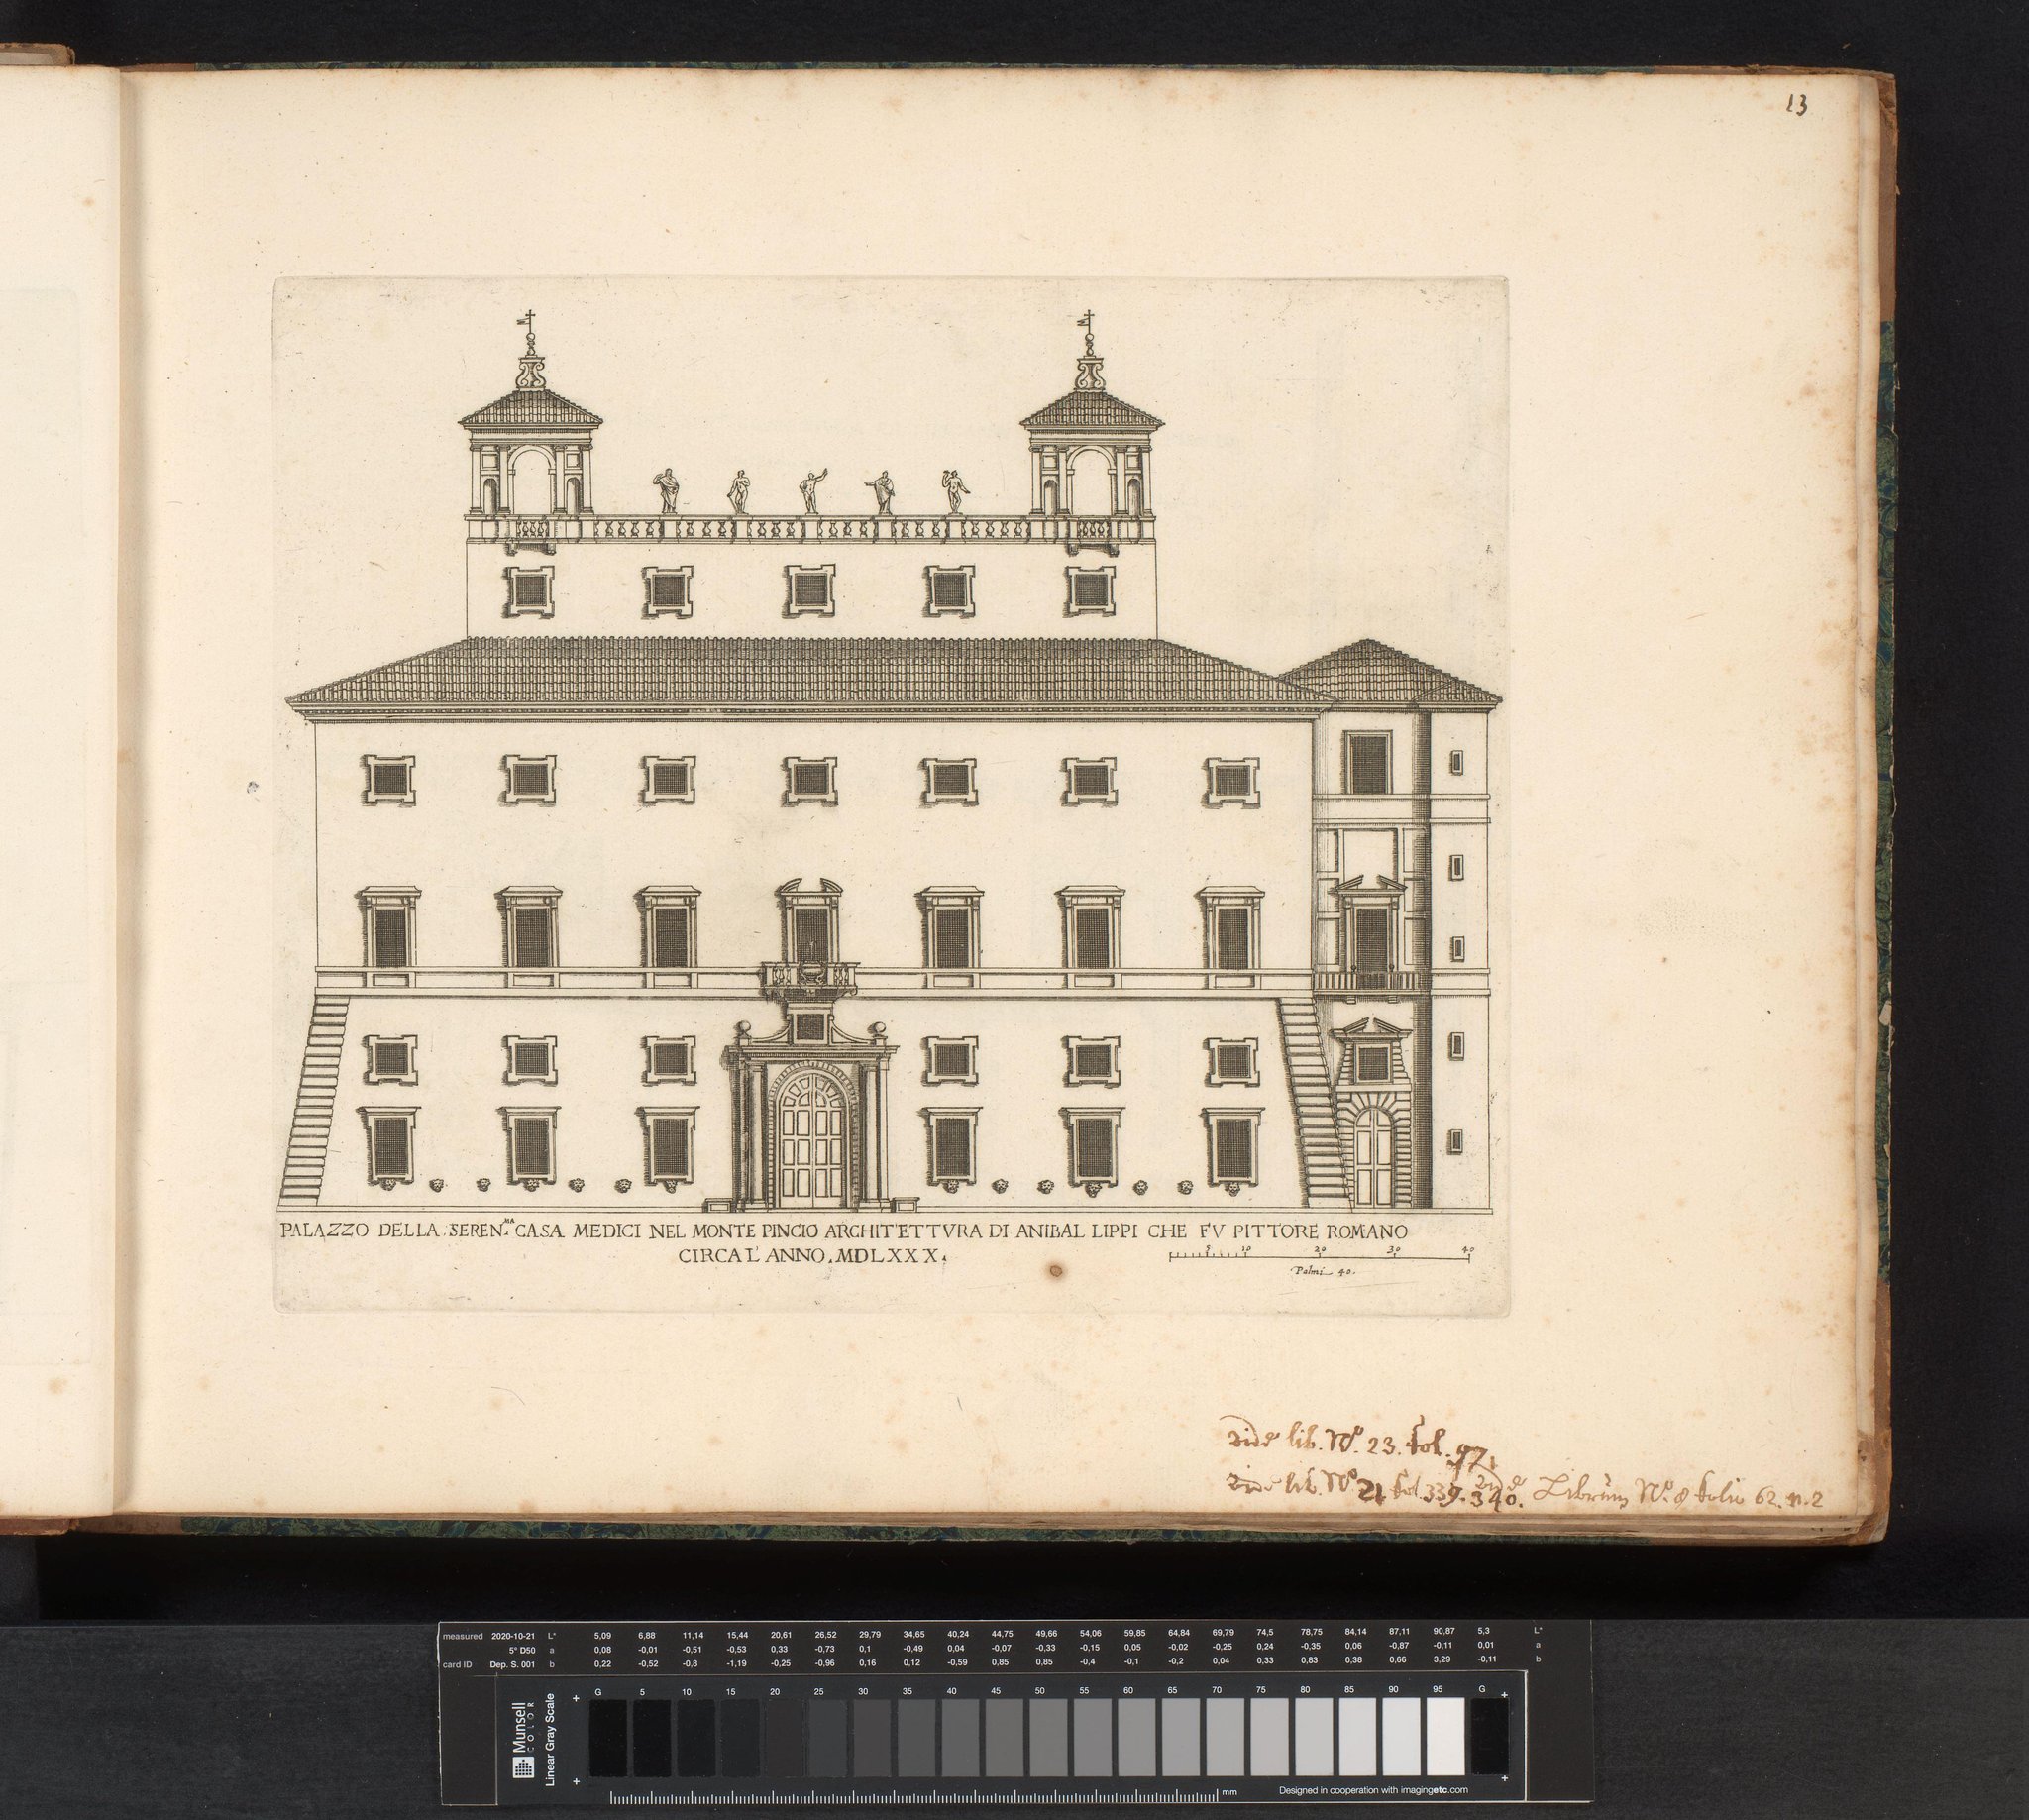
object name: album leaf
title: Façade van Villa Medici te Rome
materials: paper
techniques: etching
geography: italy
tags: palace, façade (of house or building)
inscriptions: number: ‘13’, inscription: ‘Ende lib. No. 23. fol. 971/ Ende lib. No. 21. fol. 339. 340/ Ende LIb[...] No. 8 folio 62 et 2.’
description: Deze prent maakt deel uit van de reeks getiteld: Palazzi di Roma. Deze reeks bestaat uit twee boeken. Boek één getiteld: Palazzi di Roma dei più celebri architetti..., bestaat uit 44 prenten die worden toegeschreven aan Giovanni Battista Falda (naam staat enkel op prent 27) en uitgegeven door Giovanni Giacomo de'Rossi. Deze 44 prenten zijn bekend in twee staten (met en zonder nummer). Boek twee getiteld: Nuovi disegni dell'architetture... libro secondo, bevat 66 prenten door Giovanni Battista Falda en Simone Felice. Deze 66 prenten zijn bekend in twee staten (met en zonder nummer).